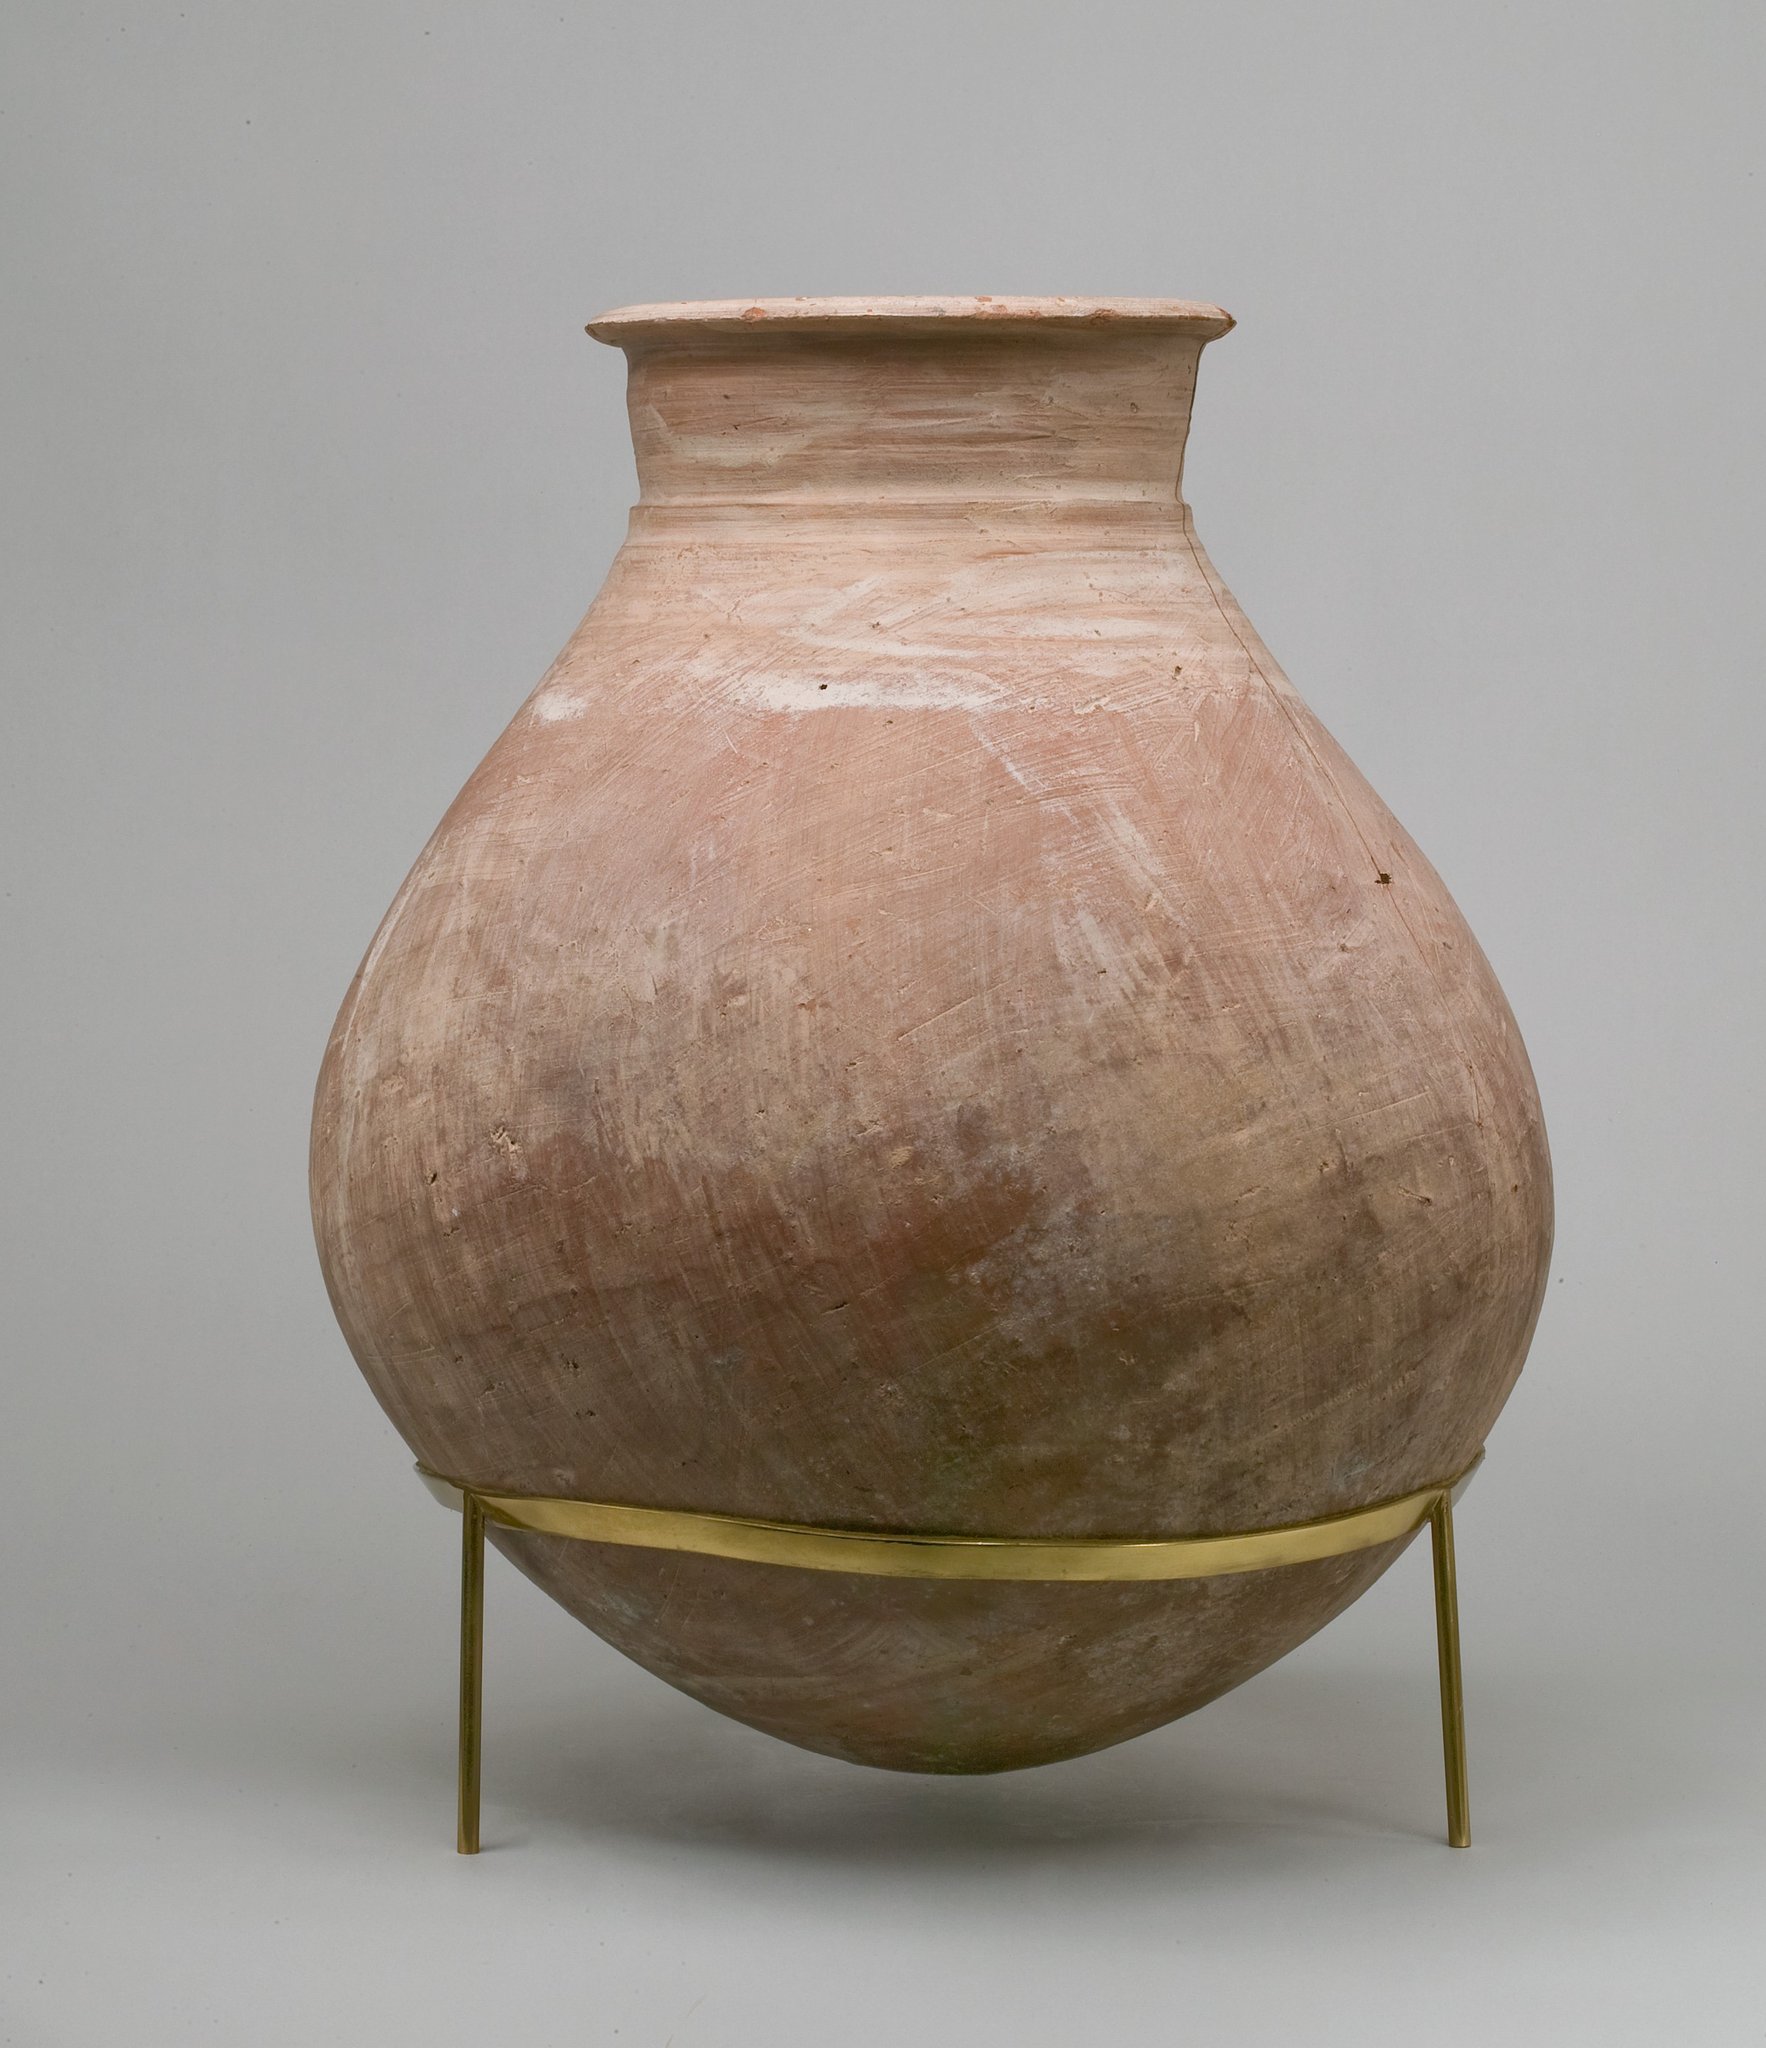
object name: pot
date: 1550-1295 BCE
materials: pottery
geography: egypt